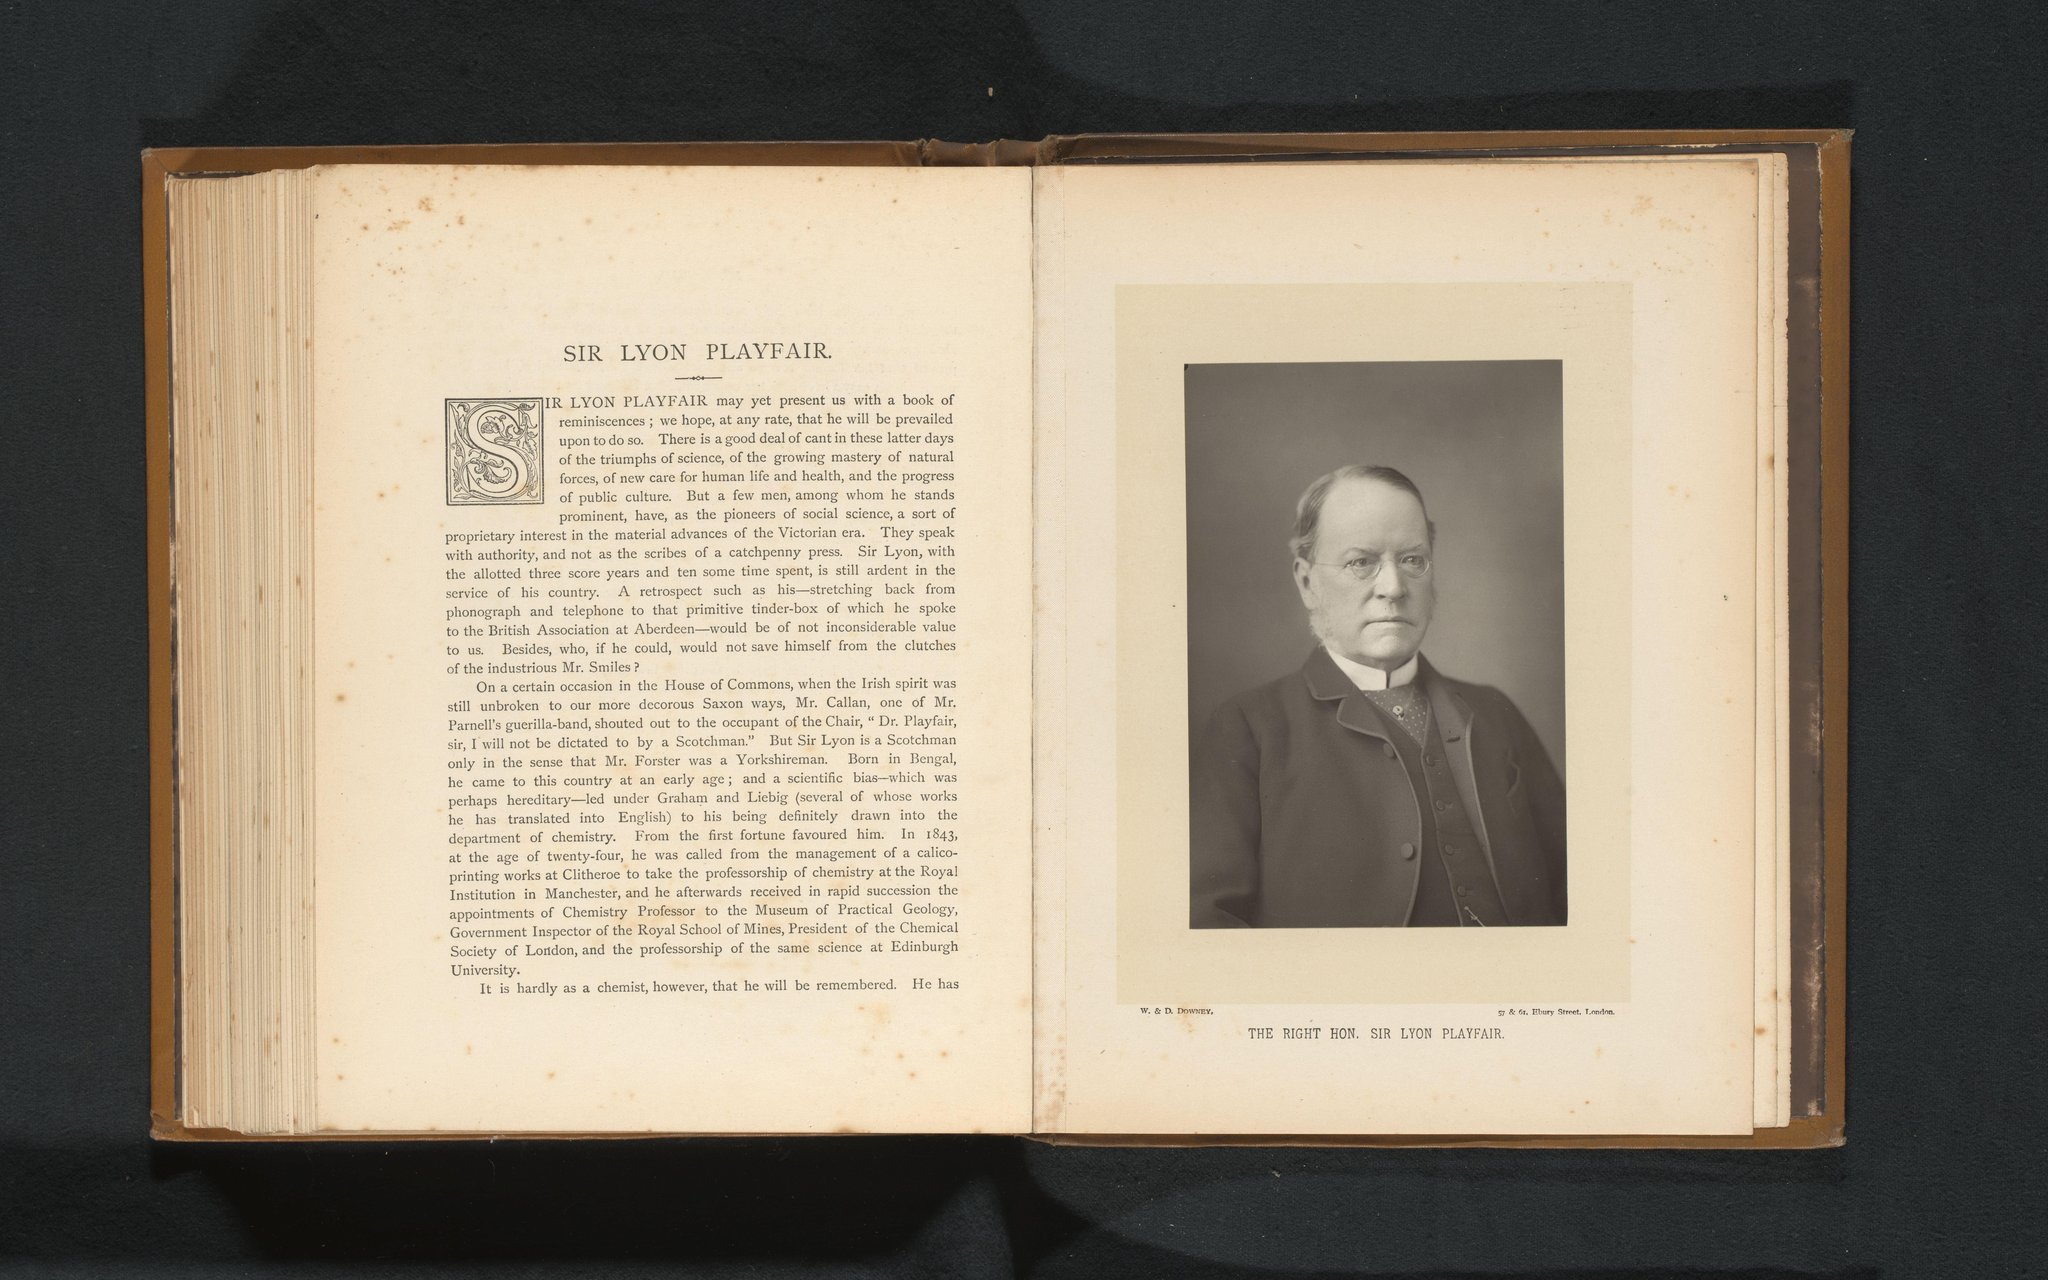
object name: photomechanical print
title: Portret van Lyon Playfair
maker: Anonymous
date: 1882-1892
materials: paper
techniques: woodburytype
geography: london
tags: politician, politician, e.g. party leader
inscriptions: inscription: ‘57 & 61, Elbury Street, London.’